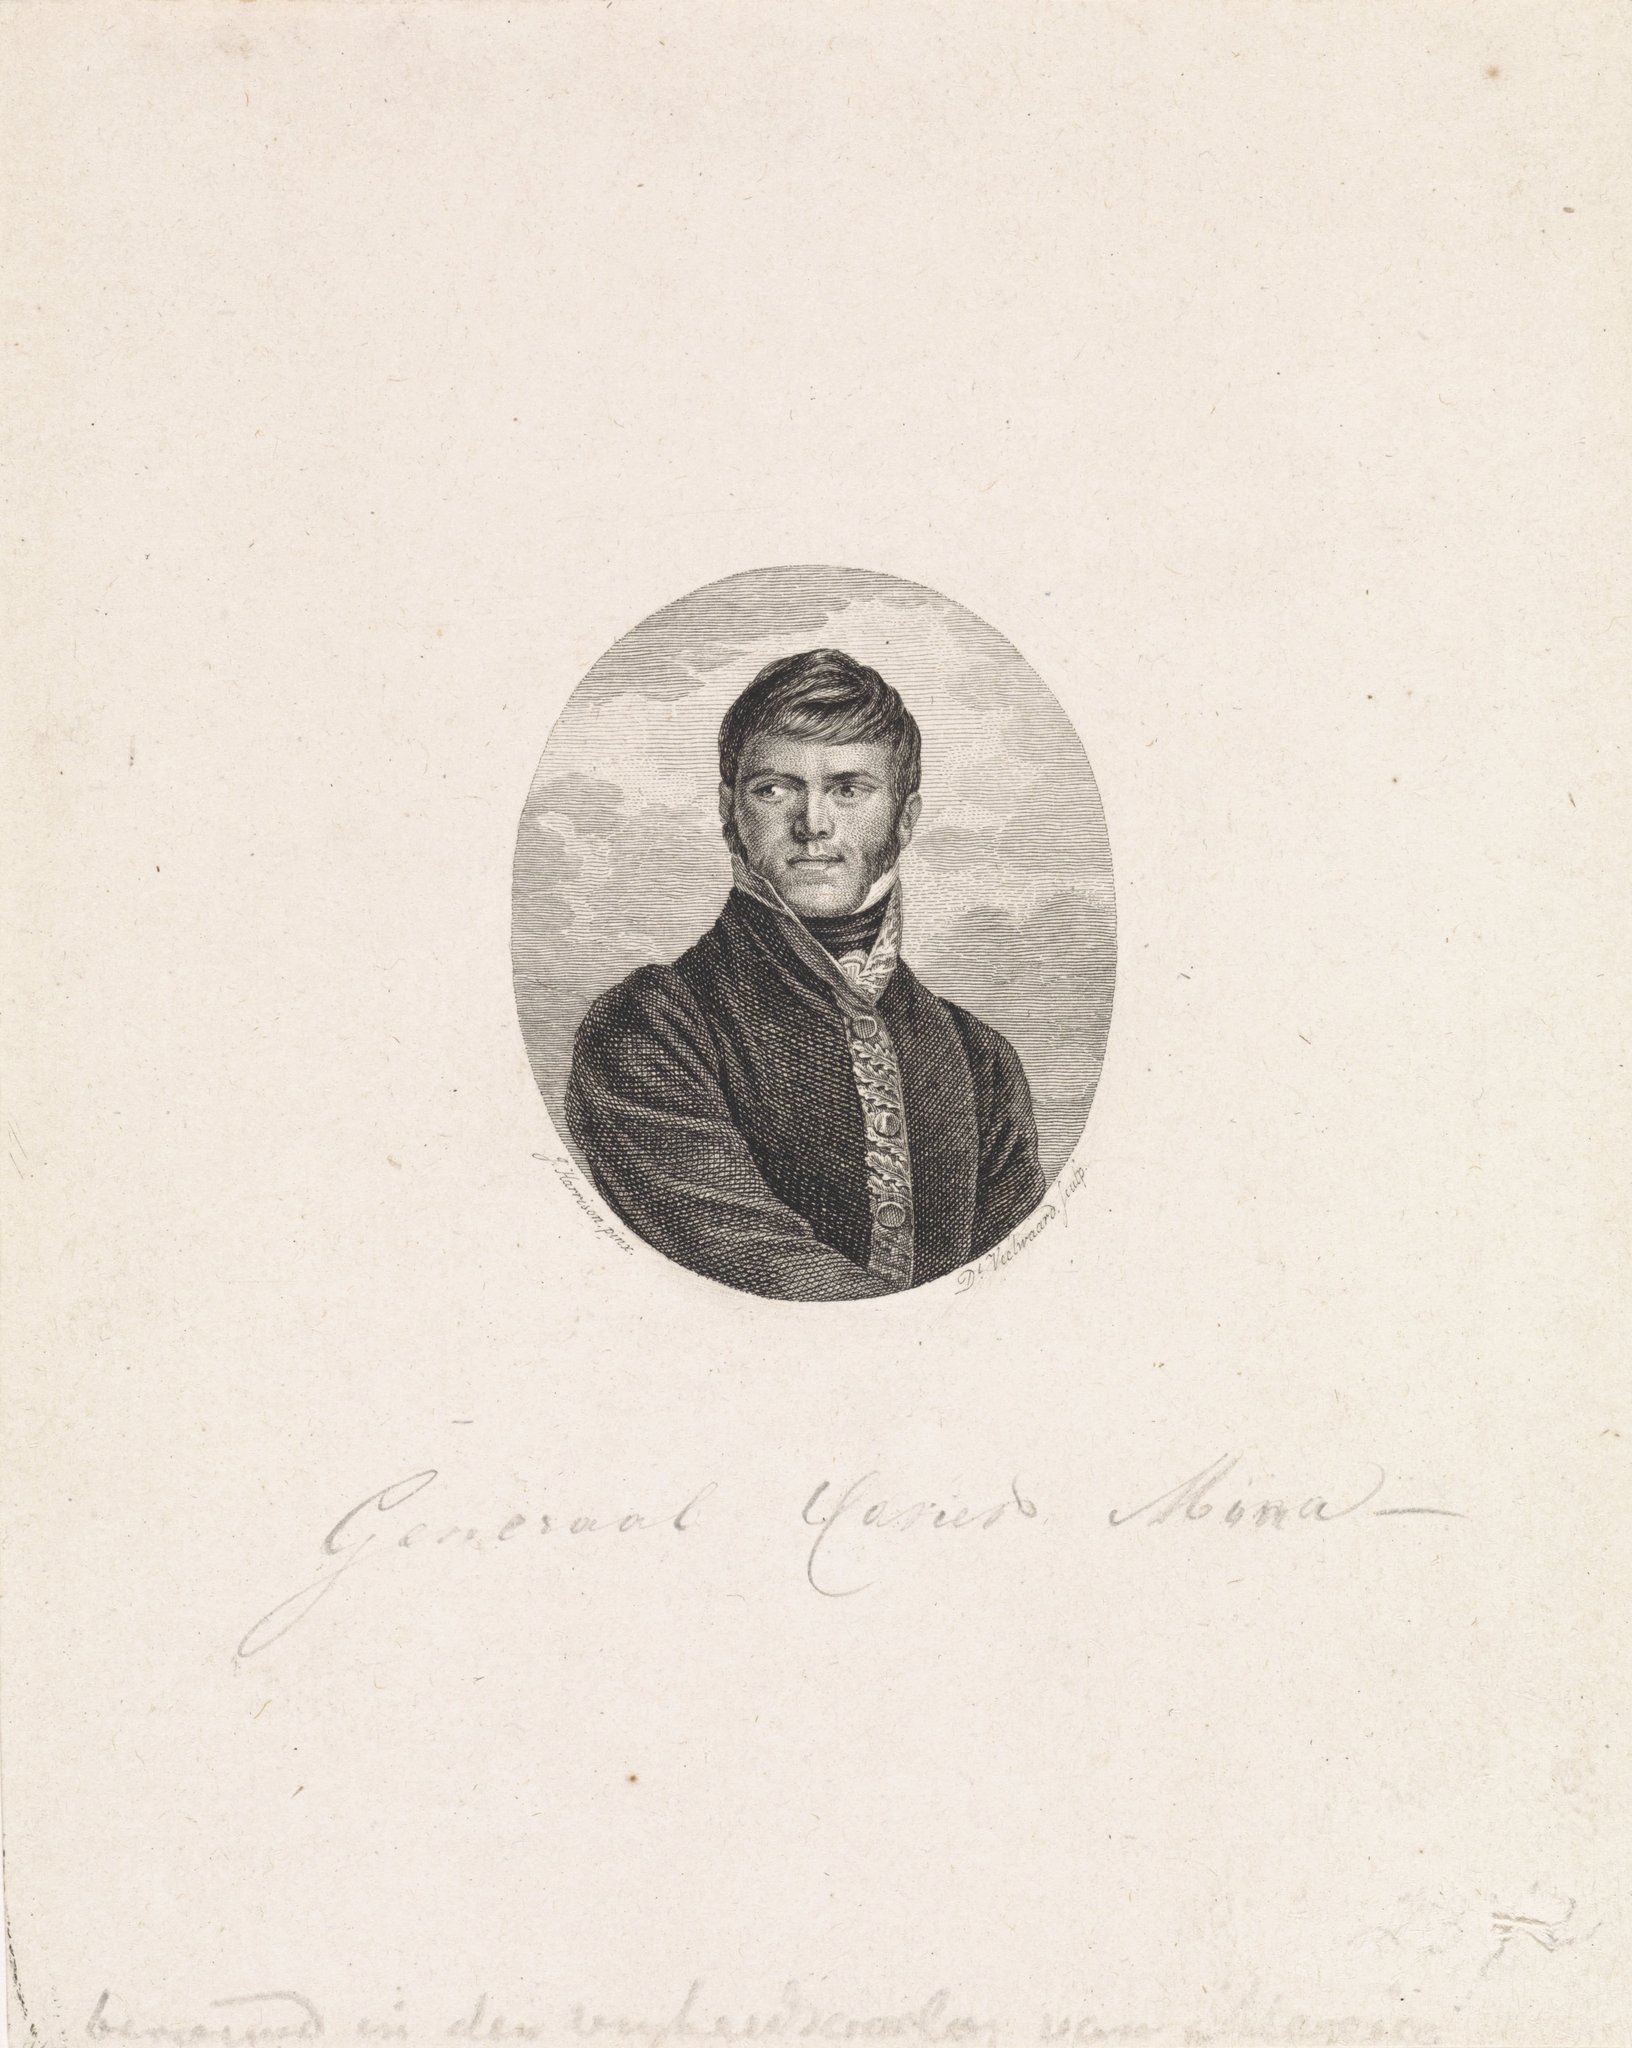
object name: print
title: Portret van de Mexicaanse guerillaleider Francisco Javier Mina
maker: daniël veelwaard (i)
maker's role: print maker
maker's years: 1766-1851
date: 1776-1851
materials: paper, pencil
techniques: engraving, etching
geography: amsterdam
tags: pénjamo, francisco javier mina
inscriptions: name: ‘Genraal Javier Mina’, collector's mark: Lugt 2228